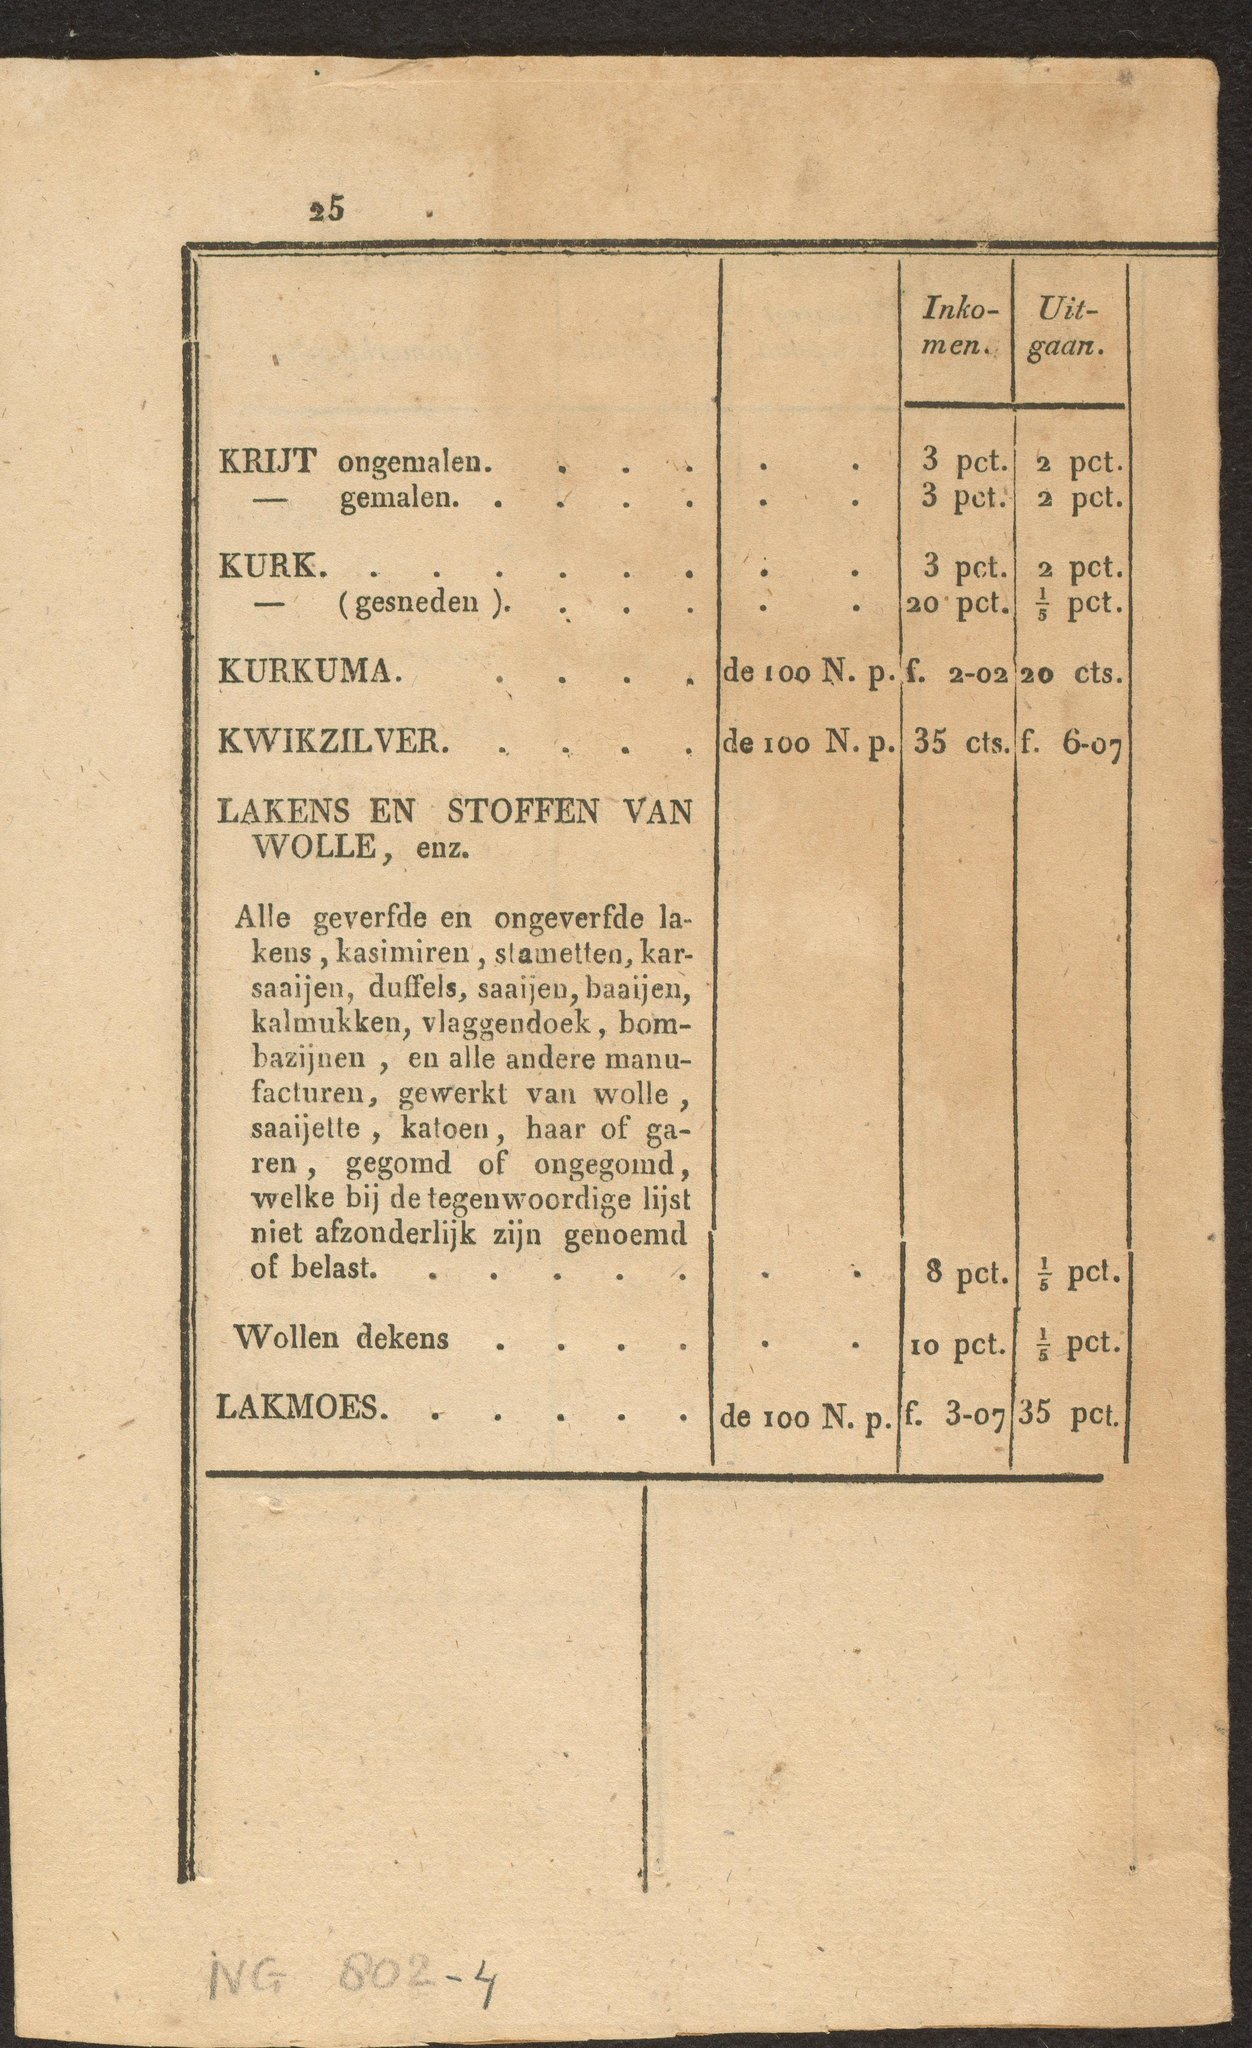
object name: brochure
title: Lijst of tarief van inkomende en uitgaande regten op alle goederen en koopmanschappen welke het koningrijk der Nederlanden zullen worden in- of uitgevoerd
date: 1819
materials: paper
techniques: folding, printing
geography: netherlands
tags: netherlands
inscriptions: date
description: Katern van een losbladige brochure, lijst met kolommen waarin gegevens over diverse handelswaar. Gedateerd en gemerkt.